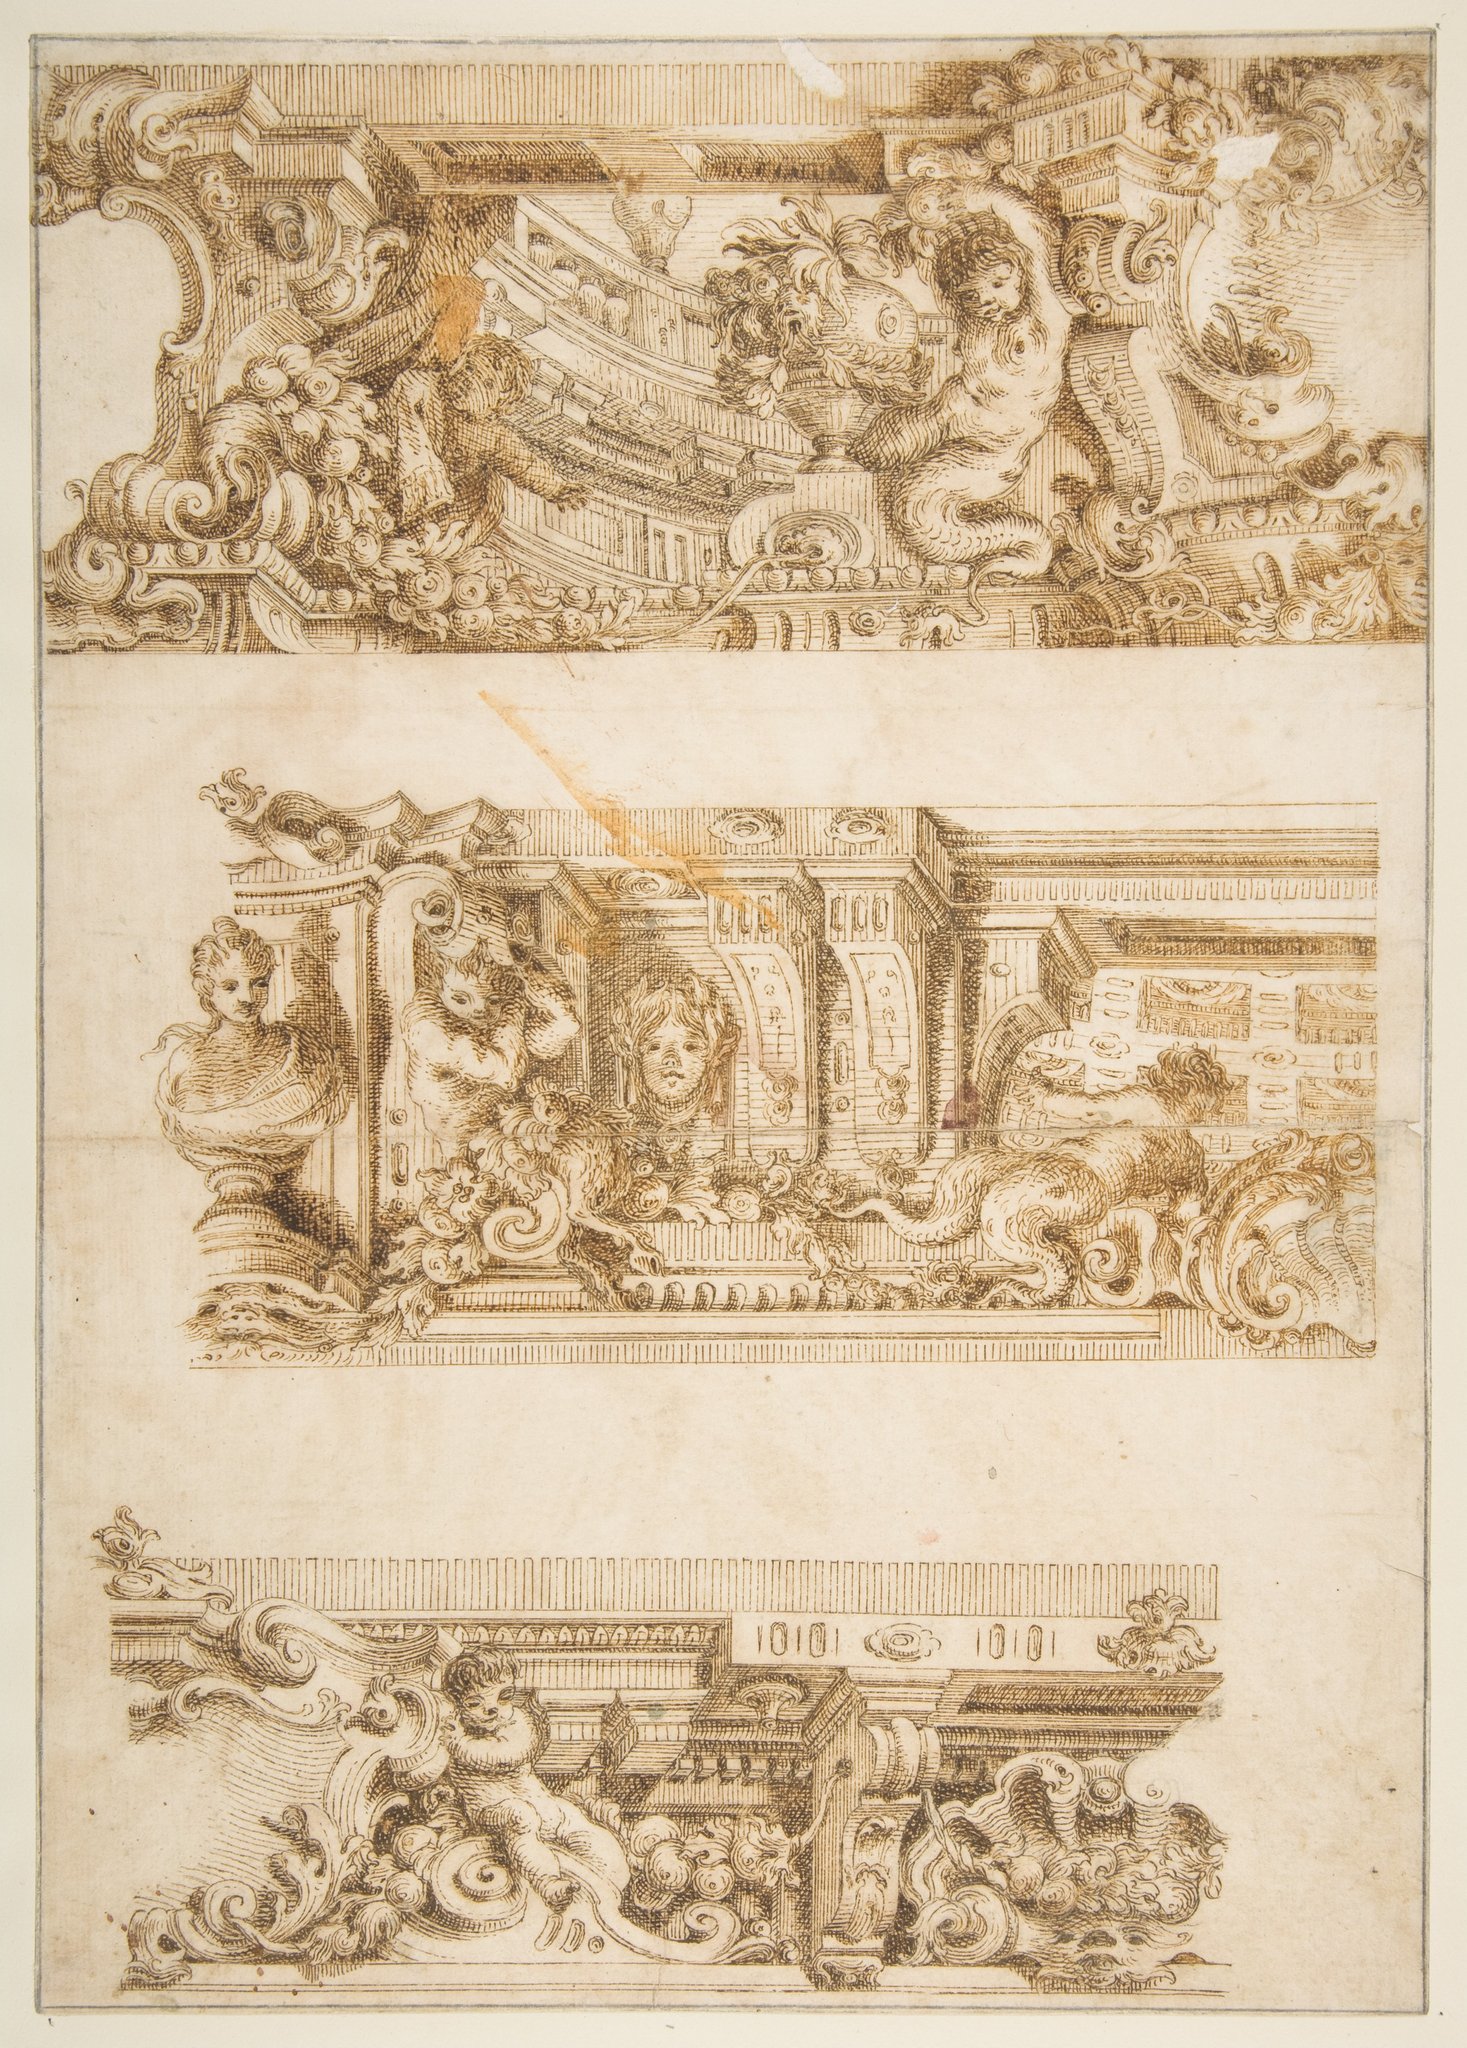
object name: drawing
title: Drawing for Engraving in Raccolta di Vari Schizzi, Venice, after Angelo Rosis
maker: antonio visentini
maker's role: artist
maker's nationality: italian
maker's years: 1688-1782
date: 1747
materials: graphite, ink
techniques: pen